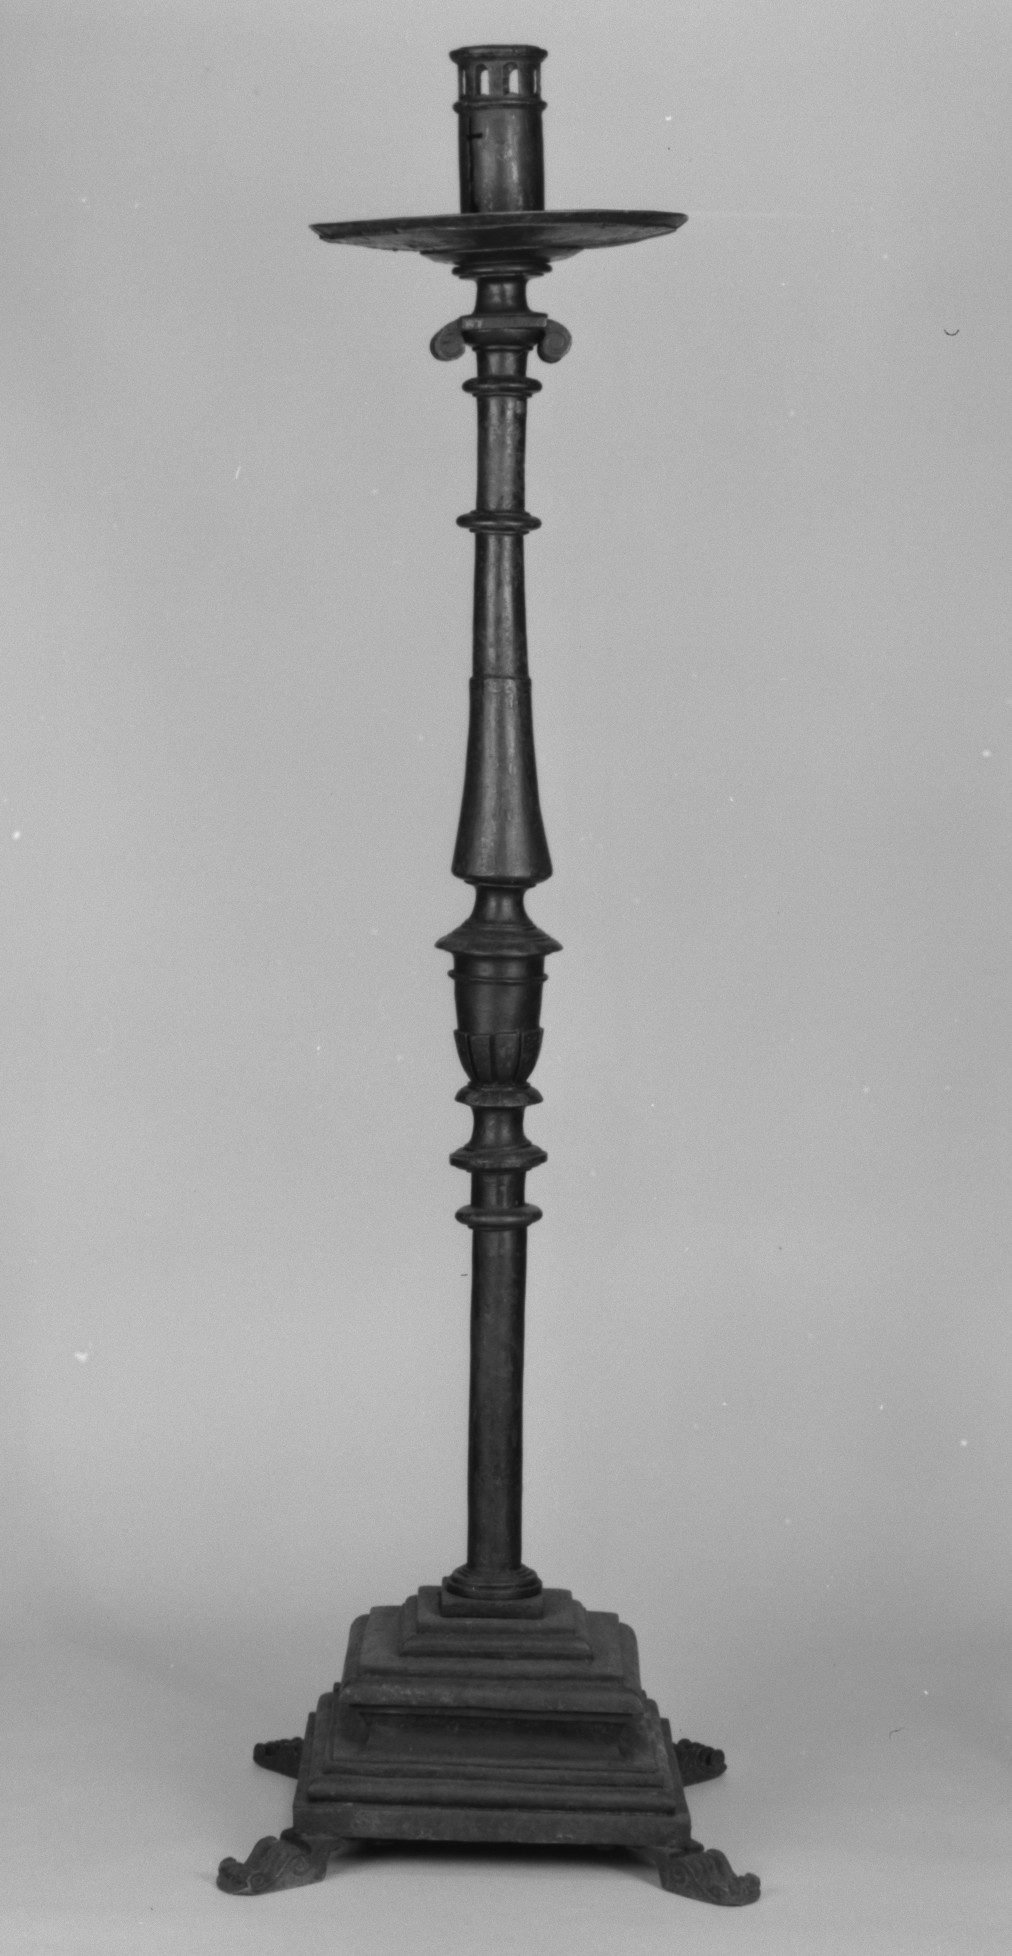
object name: candlestick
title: Pair of candlesticks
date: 1501-1600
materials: iron